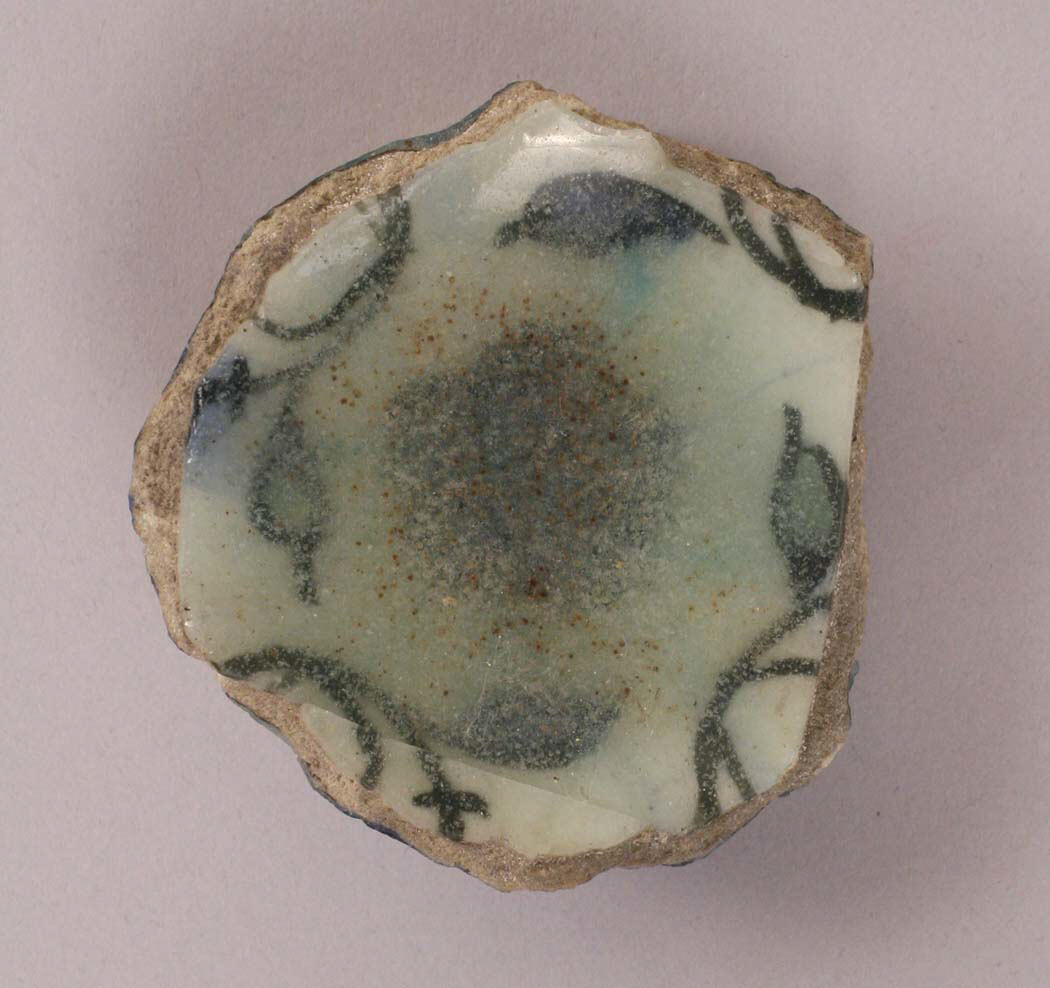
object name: fragment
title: Ceramic Fragment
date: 1201-1600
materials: glaze, stonepaste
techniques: painting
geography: egypt